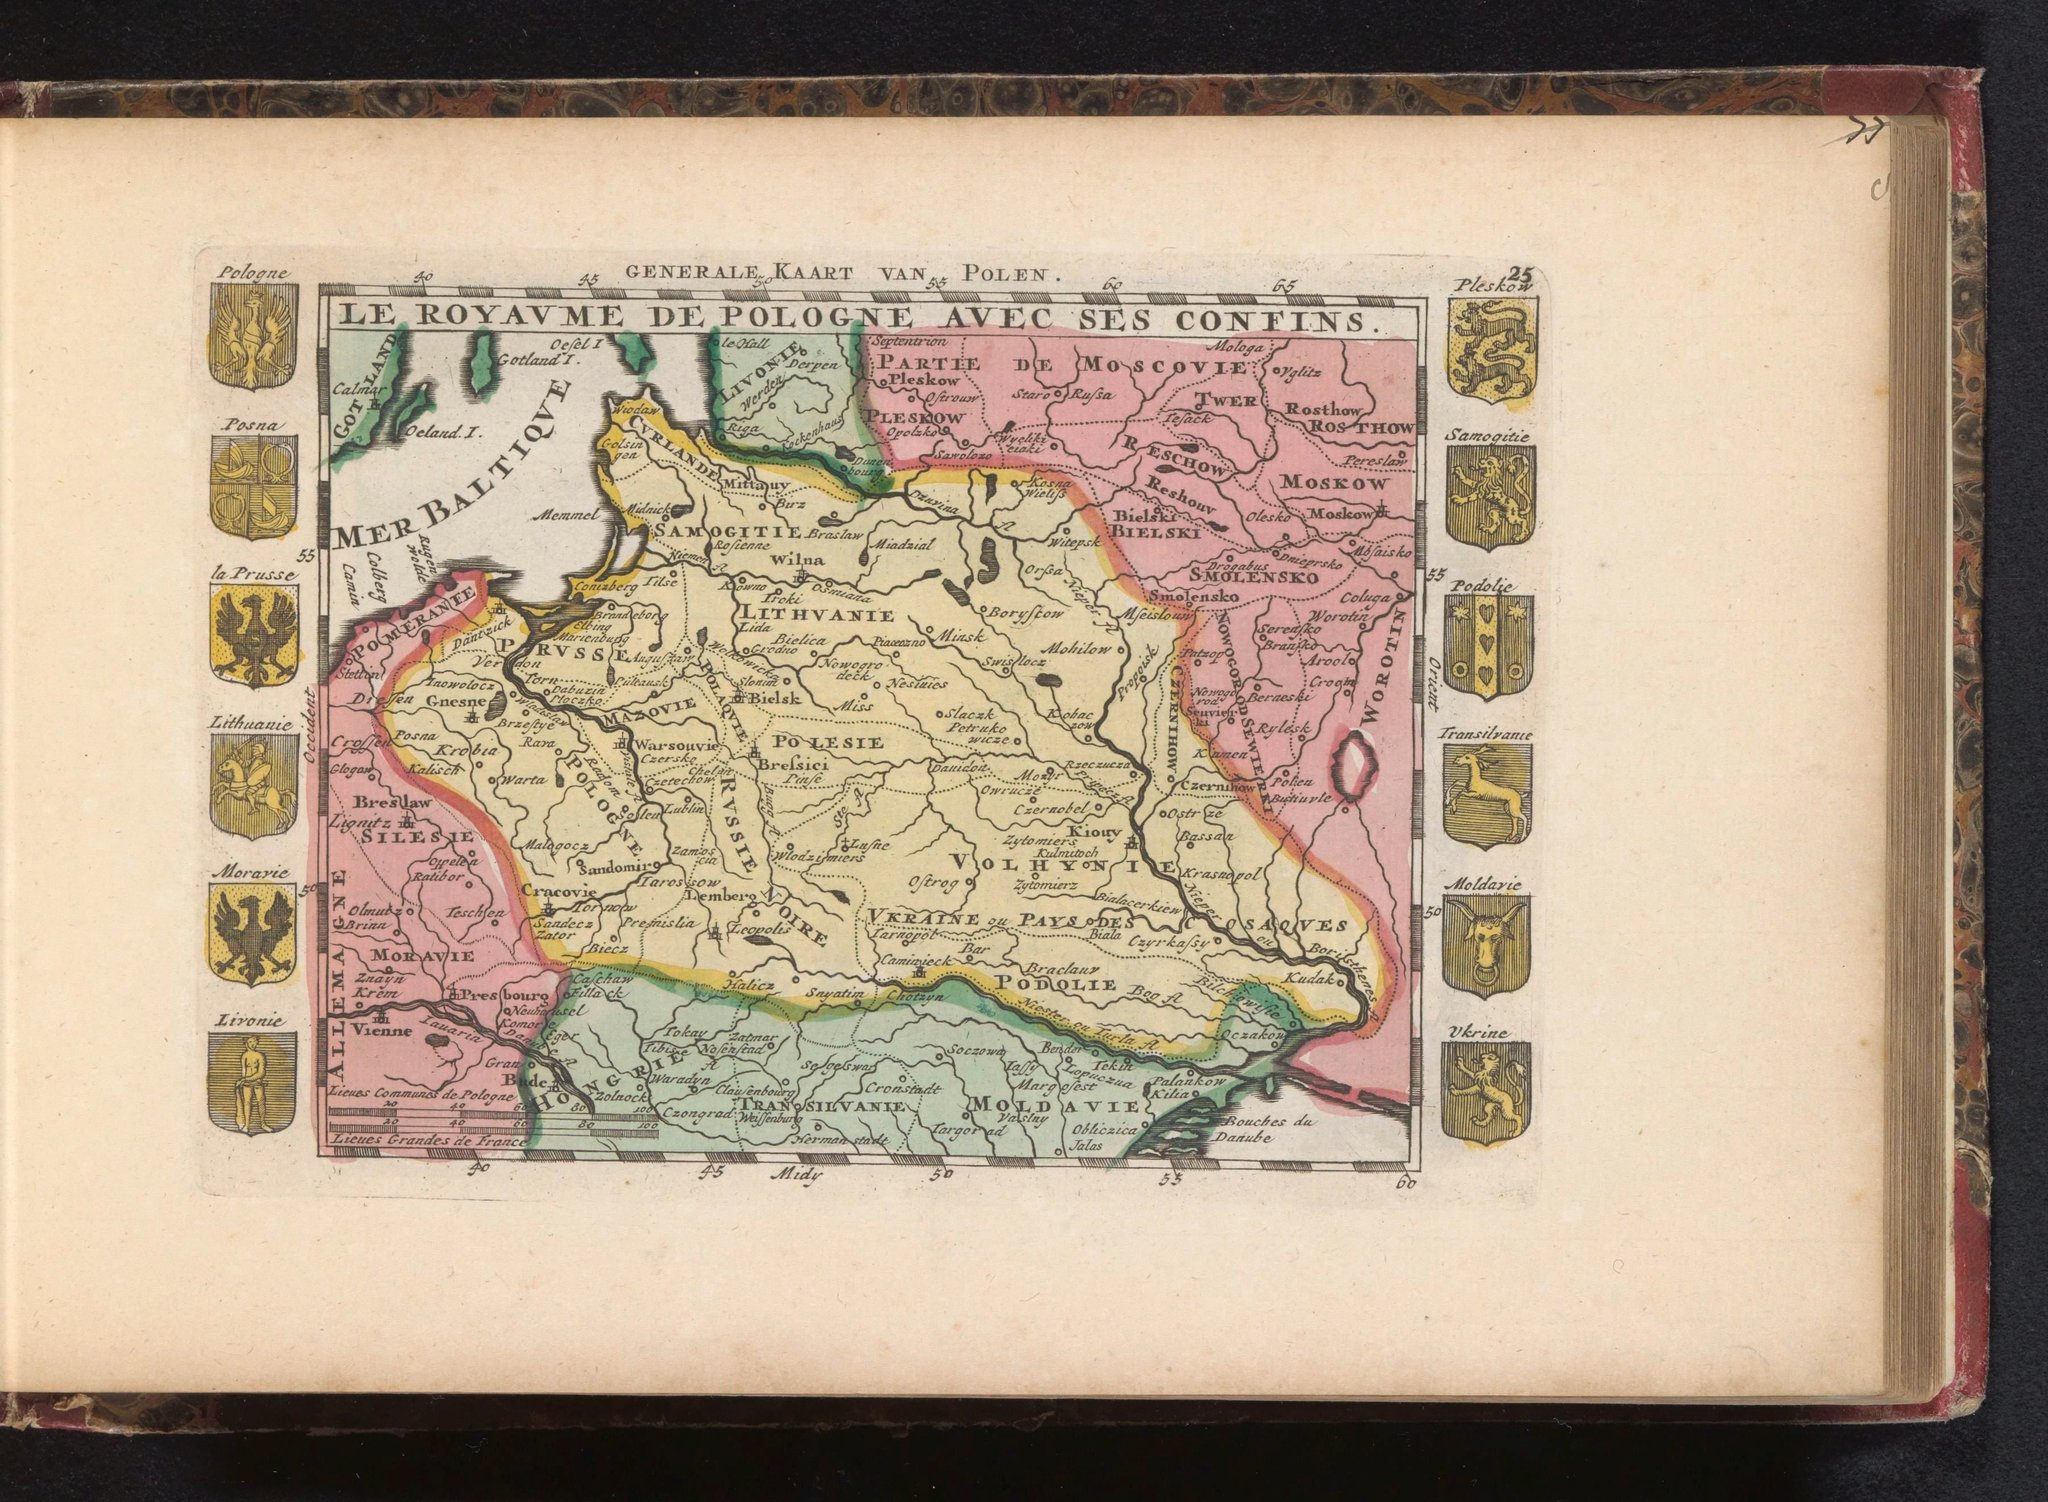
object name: print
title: Generale Kaart van Polen / Le Royavme de Pologne avec ses confins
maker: Anonymous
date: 1700-1702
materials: paper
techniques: engraving, etching, hand coloring, lacquer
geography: amsterdam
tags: maps of separate countries or regions, poland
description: Kaart van het koninkrijk Polen, aan weerszijden twaalf wapens van landsdelen. Onderdeel van een atlas met 223 kaarten van landen en steden en oorlogstaferelen in Europa in de periode ca. 1690-1735.